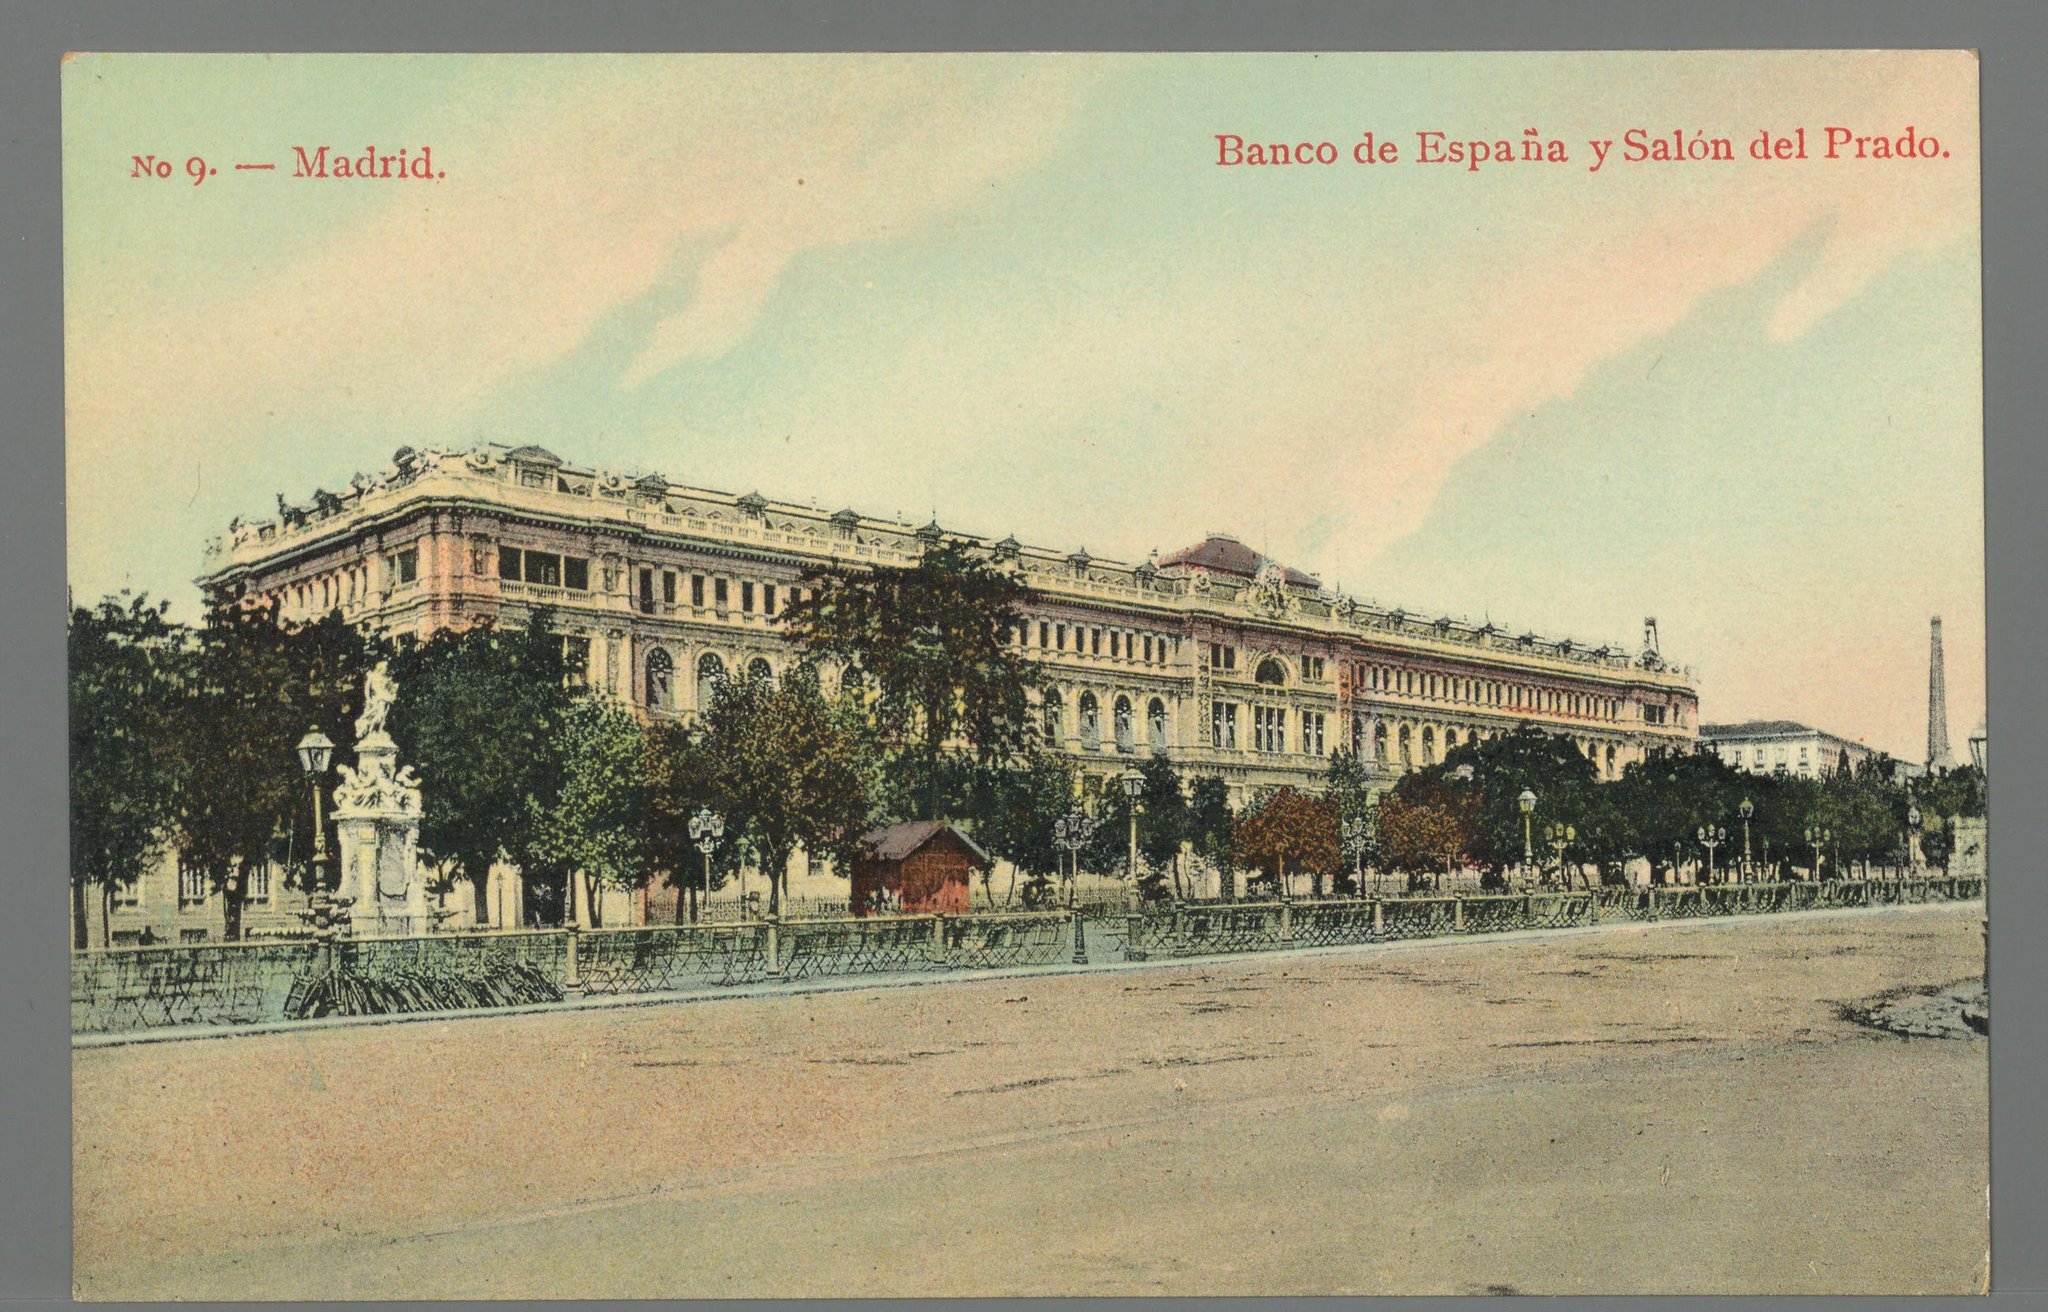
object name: photomechanical print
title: Madrid. Banco de España y Salón del Prado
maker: Anonymous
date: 1906-1930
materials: cardboard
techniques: photograph, lithograph, writing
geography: madrid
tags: avenue, boulevard, promenade, esplanade, bank